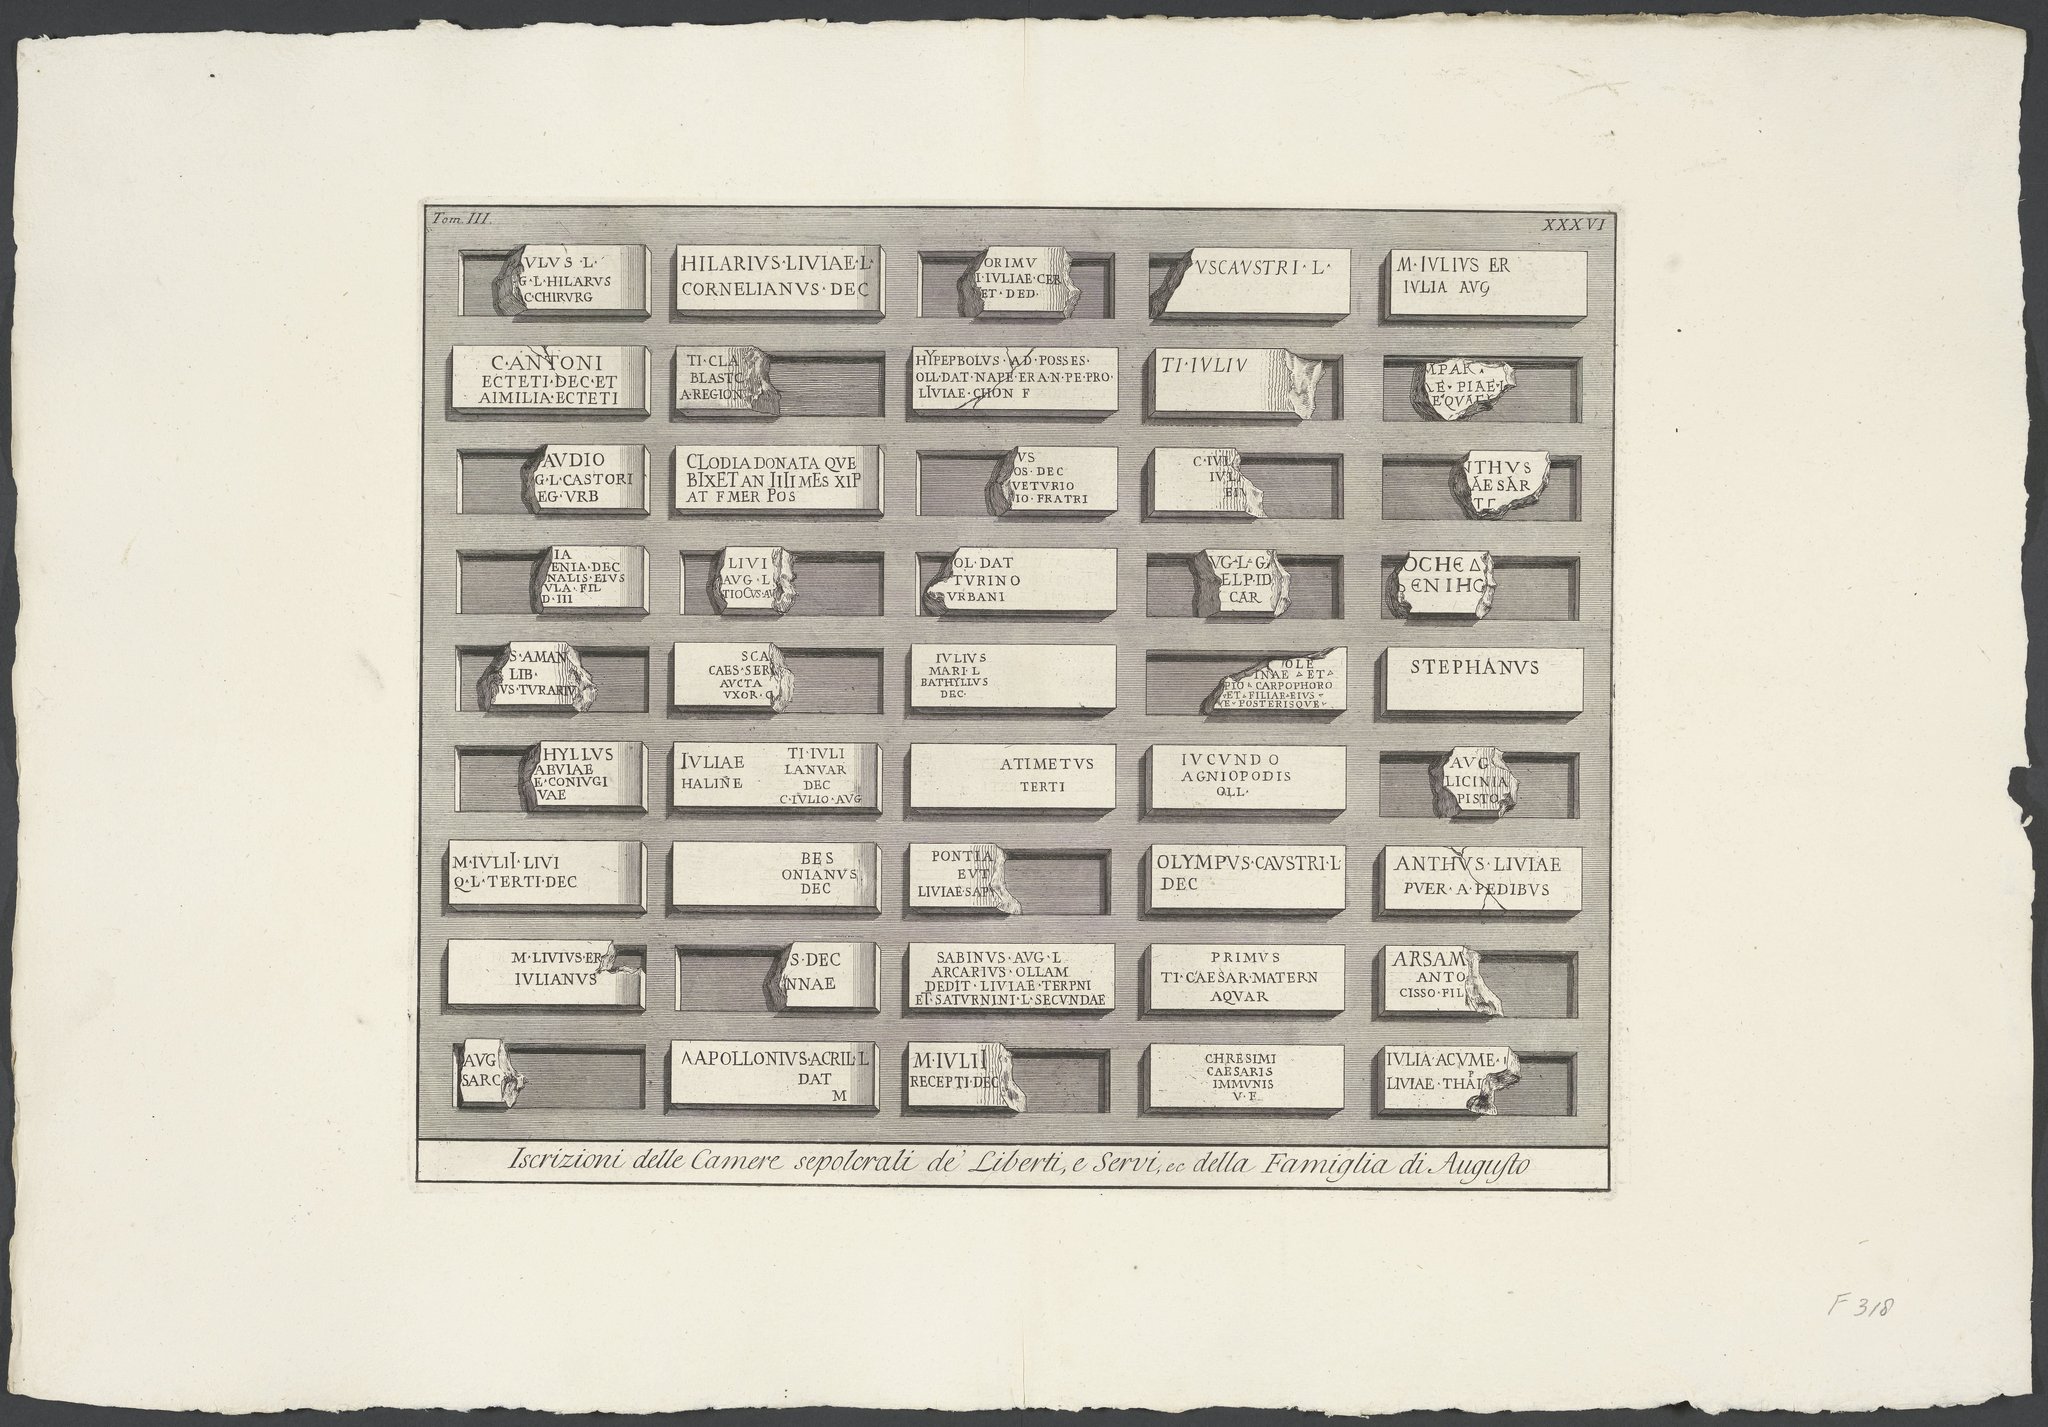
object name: print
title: Inscripties uit de graftombe van de vrijgelatenen en slaven van de familie van Augustus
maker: giovanni battista piranesi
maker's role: designer, draughtsman, print maker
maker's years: 1720-1778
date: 1756-1757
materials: paper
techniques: etching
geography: rome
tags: inscription, slavery; serfs and enslaved persons, freedom ~ slavery, italy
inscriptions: collector's mark: Lugt 2228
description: Deze prent maakt deel uit van de serie 'Le Antichità Romane'. Piranesi deed meer dan acht jaar voorstudie voor deze 250 platen tellende serie die in vier volumes werd uitgegeven. Hij produceerde de prenten tussen ca. 1756 en 1757. De serie bevat ook prenten door of naar andere prentmakers, onder wie Francesco Bianchini en Girolamo Rossi.